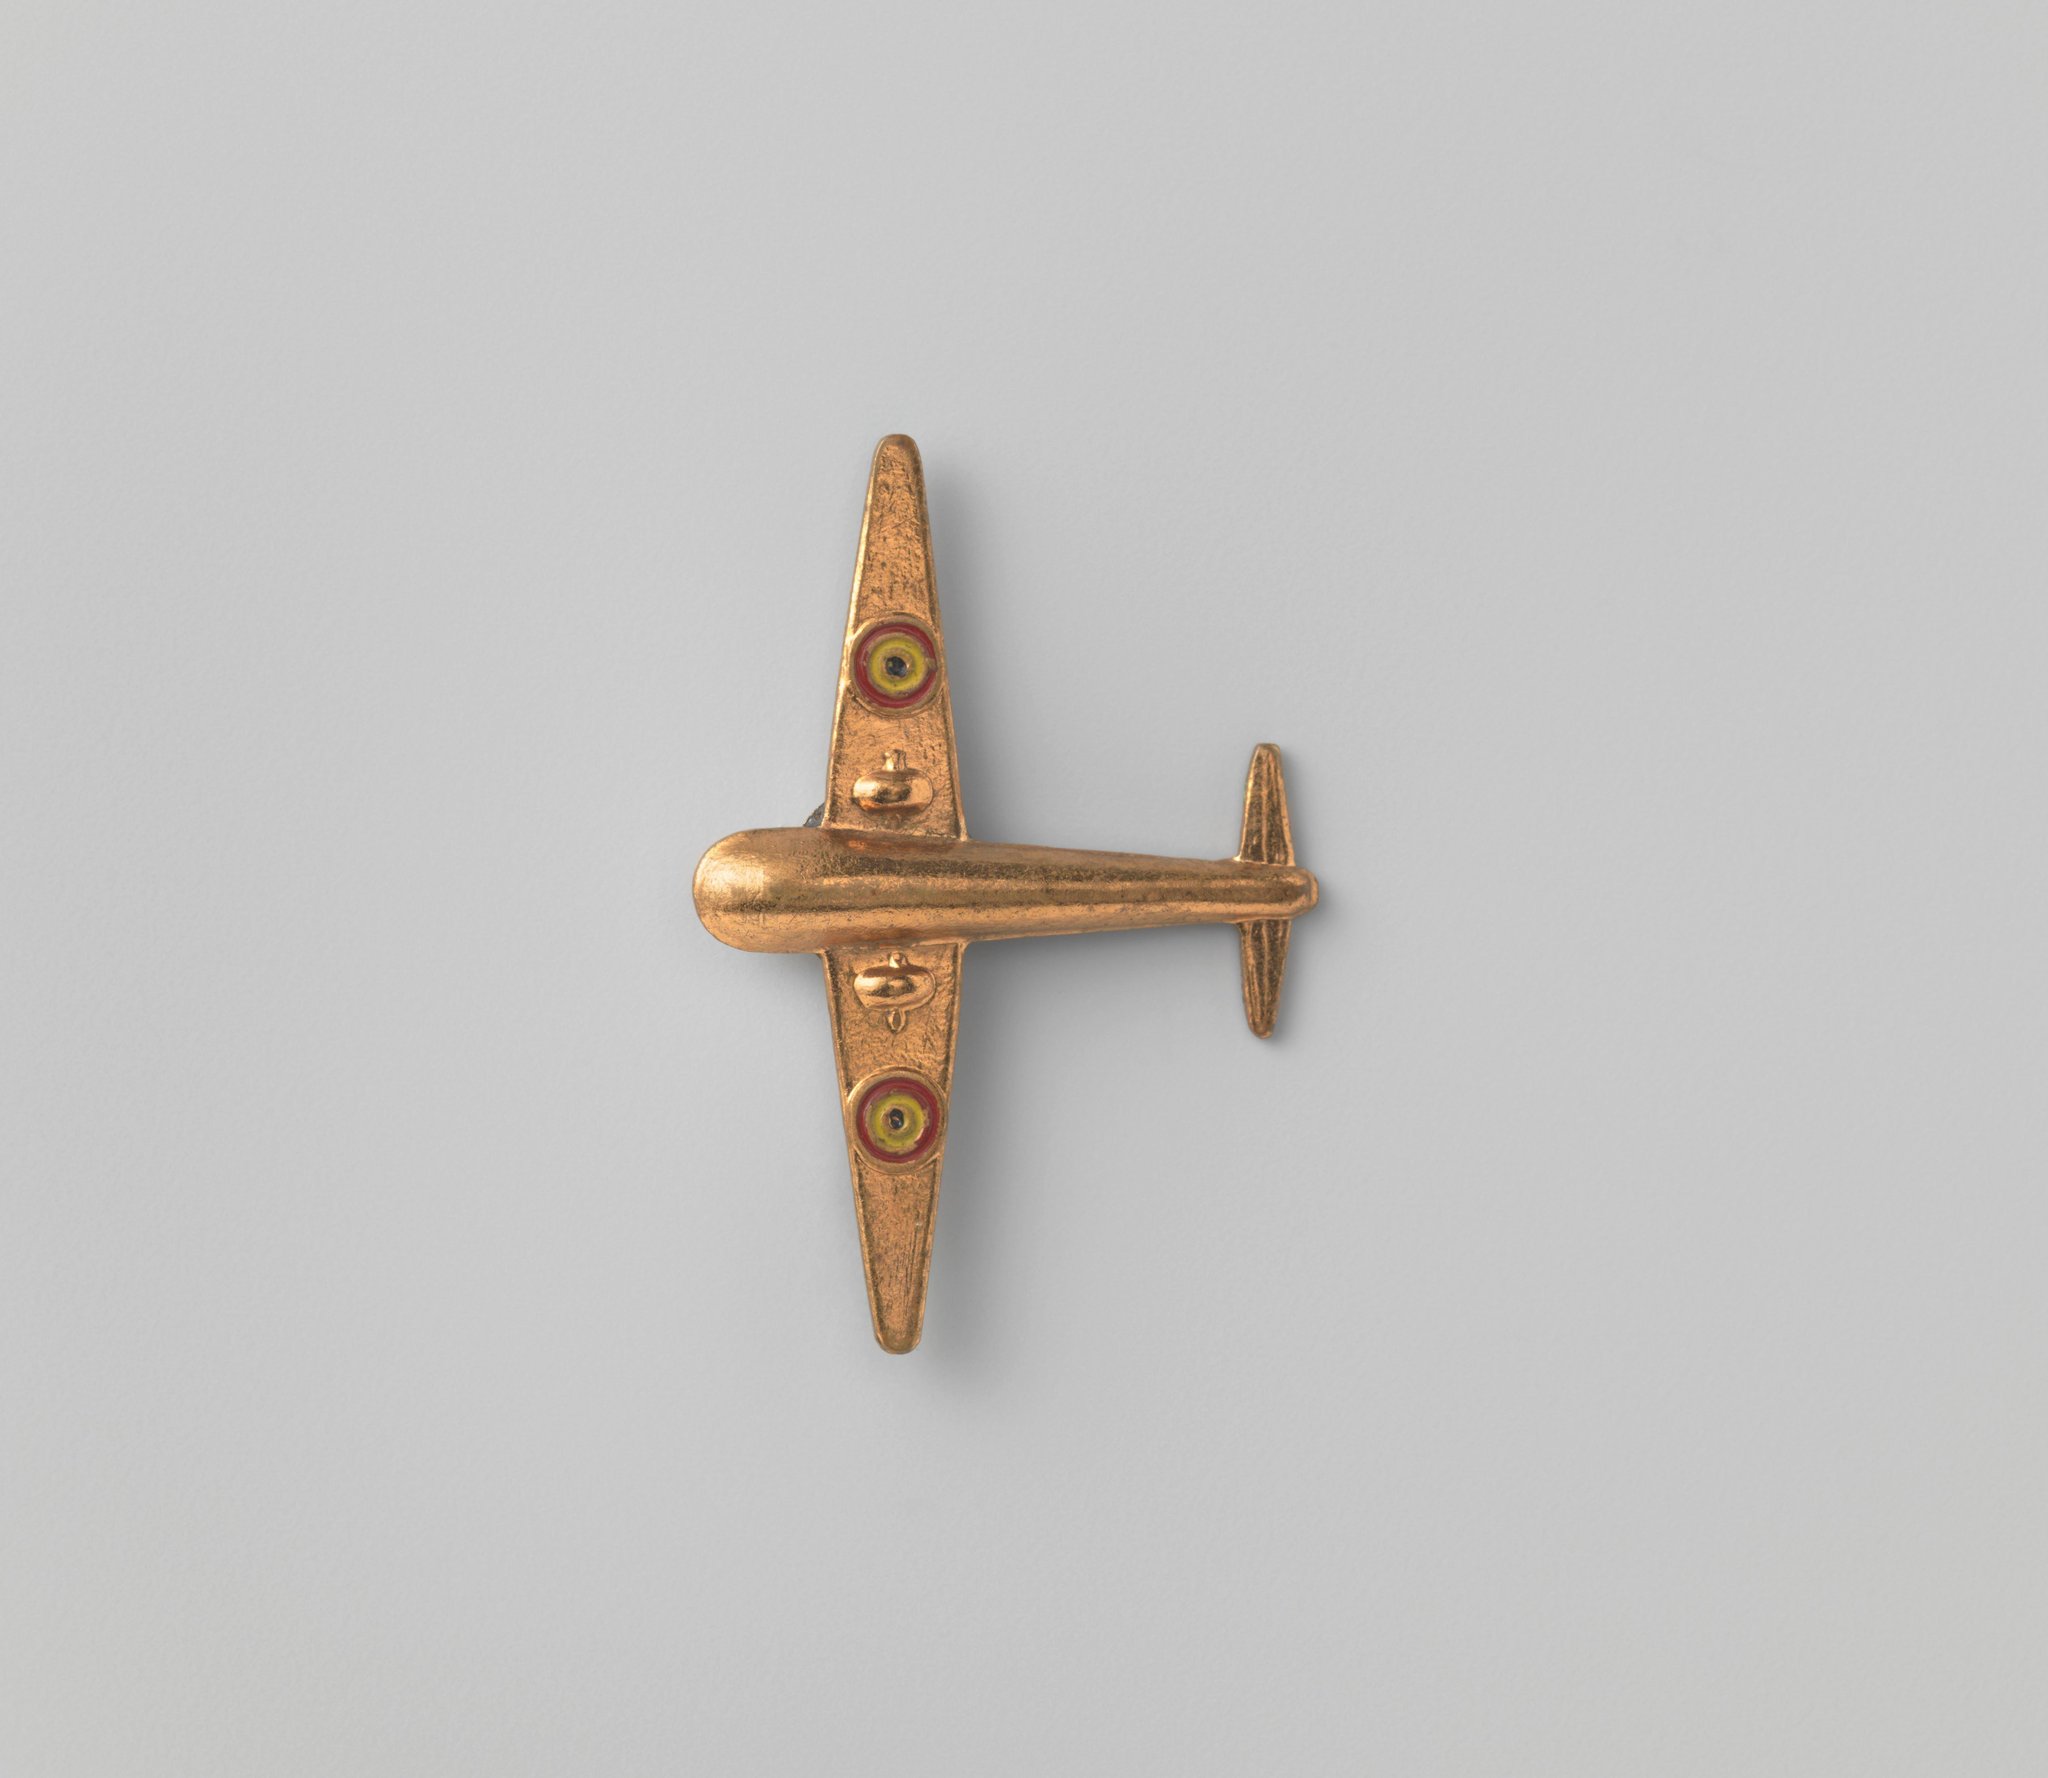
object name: brooch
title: Brooch in the form of an aeroplane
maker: Anonymous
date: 1940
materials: metal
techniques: enameling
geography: netherlands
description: Silent Resistance –War and Liberation Jewellery During the Second World War, small pieces of jewellery were worn in the Netherlands as a silent protest against the German occupier. In April 1941, Dutch coins were officially confiscated for the war industry. As jewellery did not have to be surrendered, coins were quickly transformed into rings, brooches, pins and bracelets. A portrait of Queen Wilhelmina was worn as a sign of resistance, as well as a token of loyalty to the royal family. Margriet Francisca, the third daughter of Princess Juliana and Prince Bernard, was born in Canada in January 1943. The pin with the three yellow chicks refers to the three young princesses Beatrix, Irene and Margriet and the steadfastness of the Dutch royal family. After the liberation, coins and silver were used for jewellery conveying messages of hope for a peaceful future.